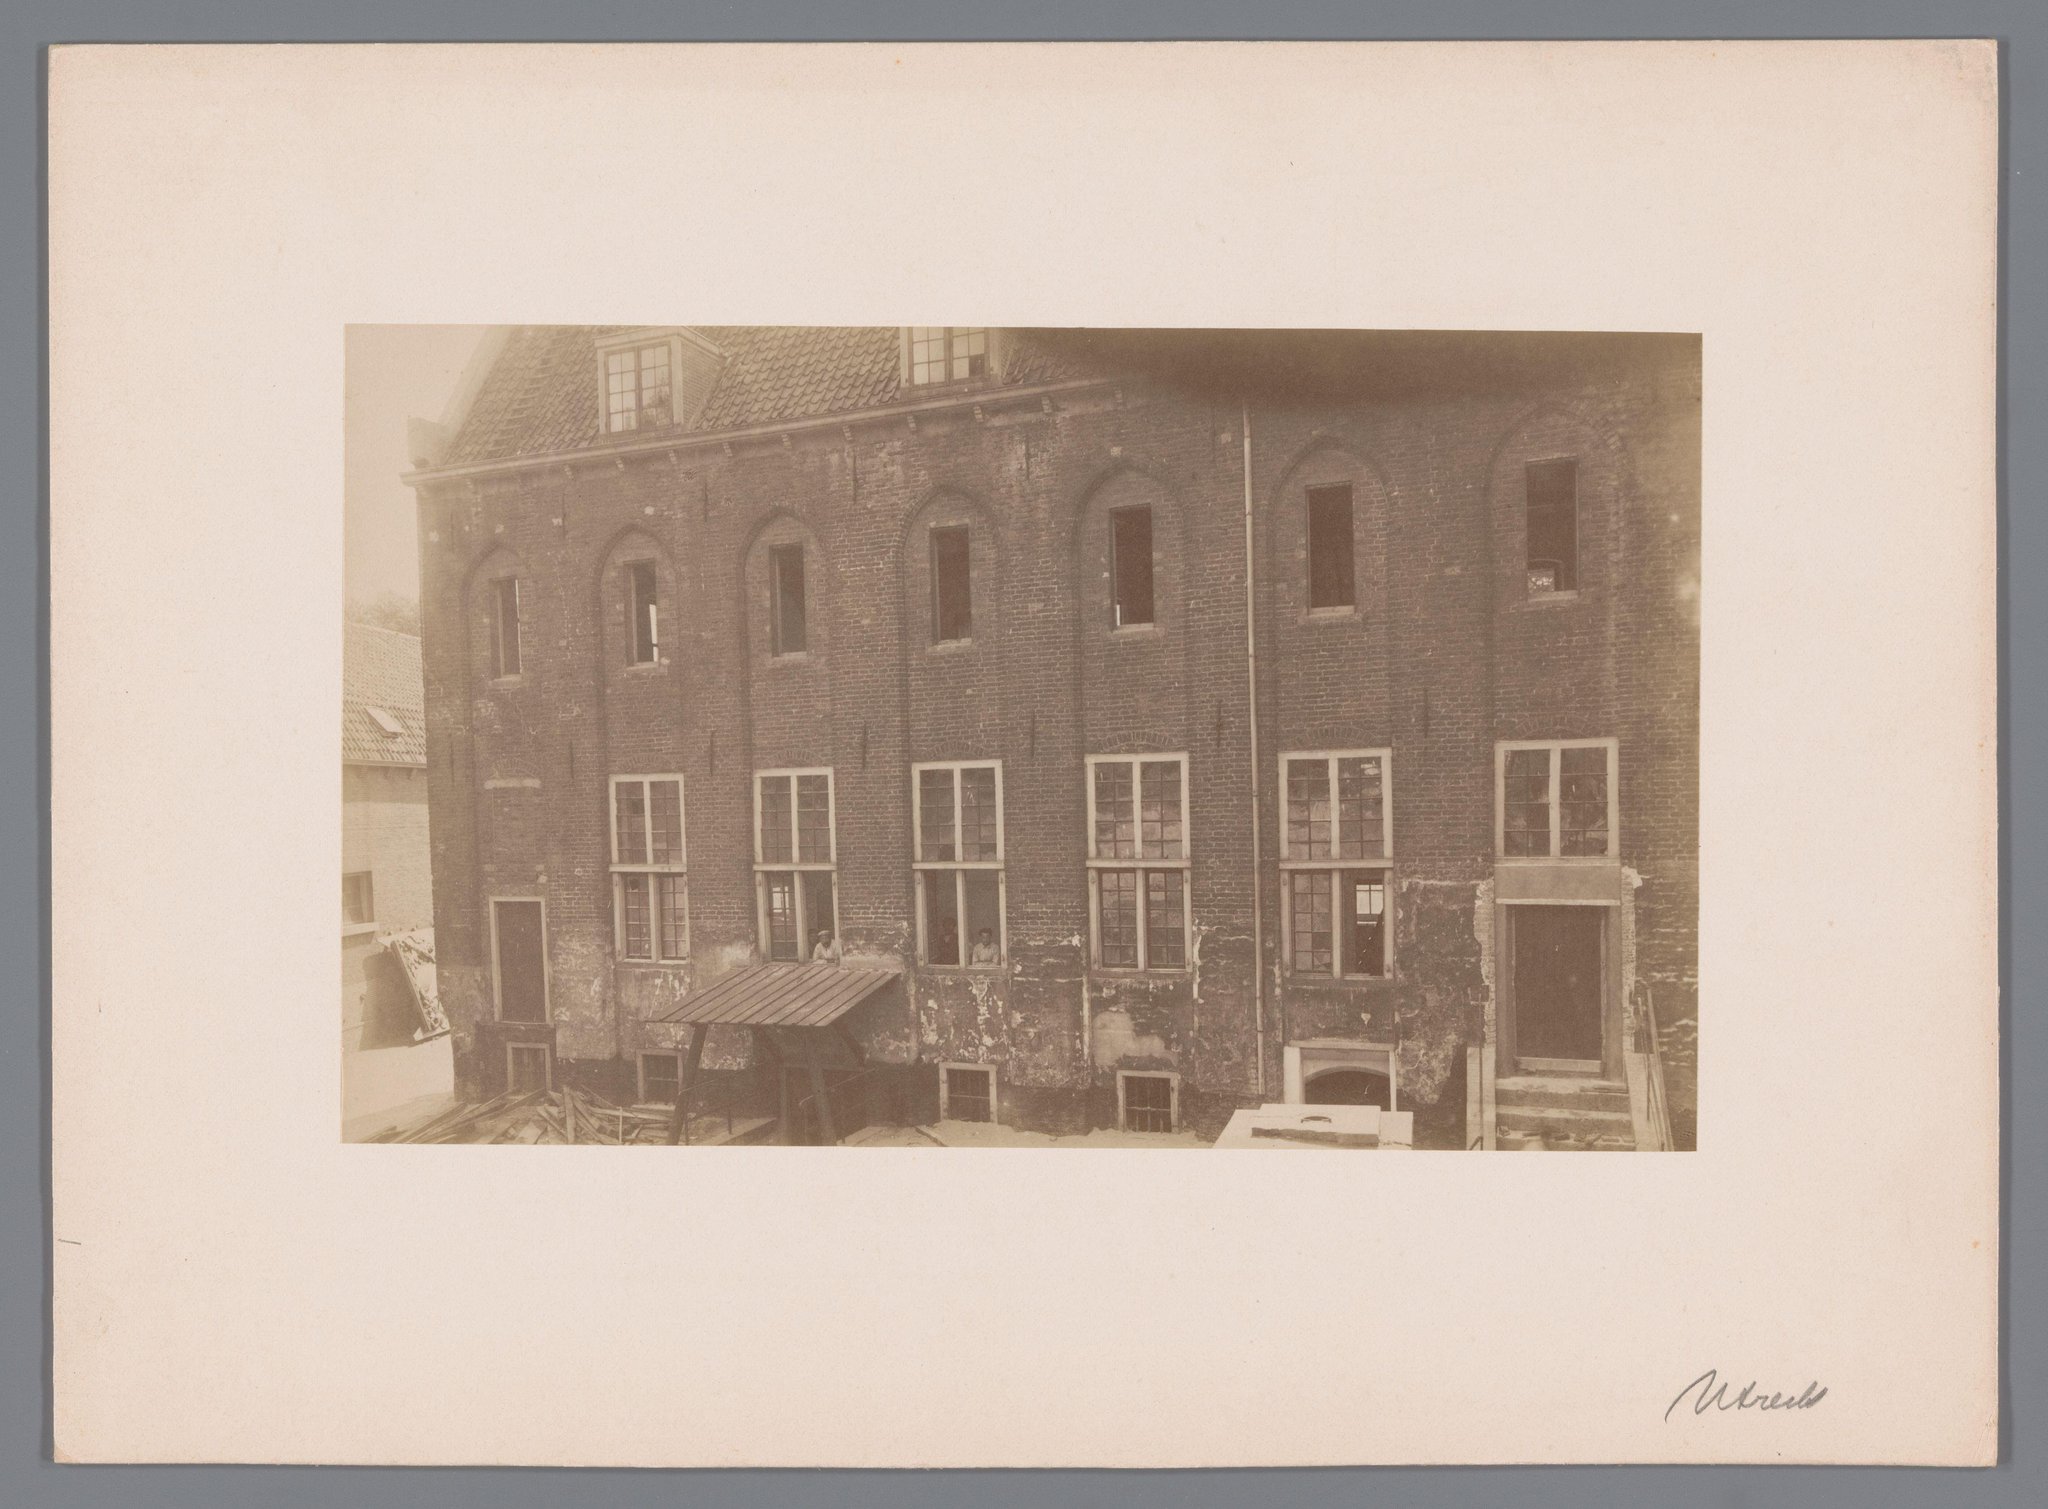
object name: photograph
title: Gezicht op het voormalige Agnietenklooster te Utrecht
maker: anoniem (monumentenzorg)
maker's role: fotograaf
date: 1902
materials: cardboard, photographic support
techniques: albumen print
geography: utrecht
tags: cloisters ~ monastery, utrecht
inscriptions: annotation: ‘Utrecht (U.)/ Voormalig st. Agnietenklooster thans militair gebouw/ gedeelte grenzende a/d kerk/ juni 1902’, annotation: ‘Utrecht’